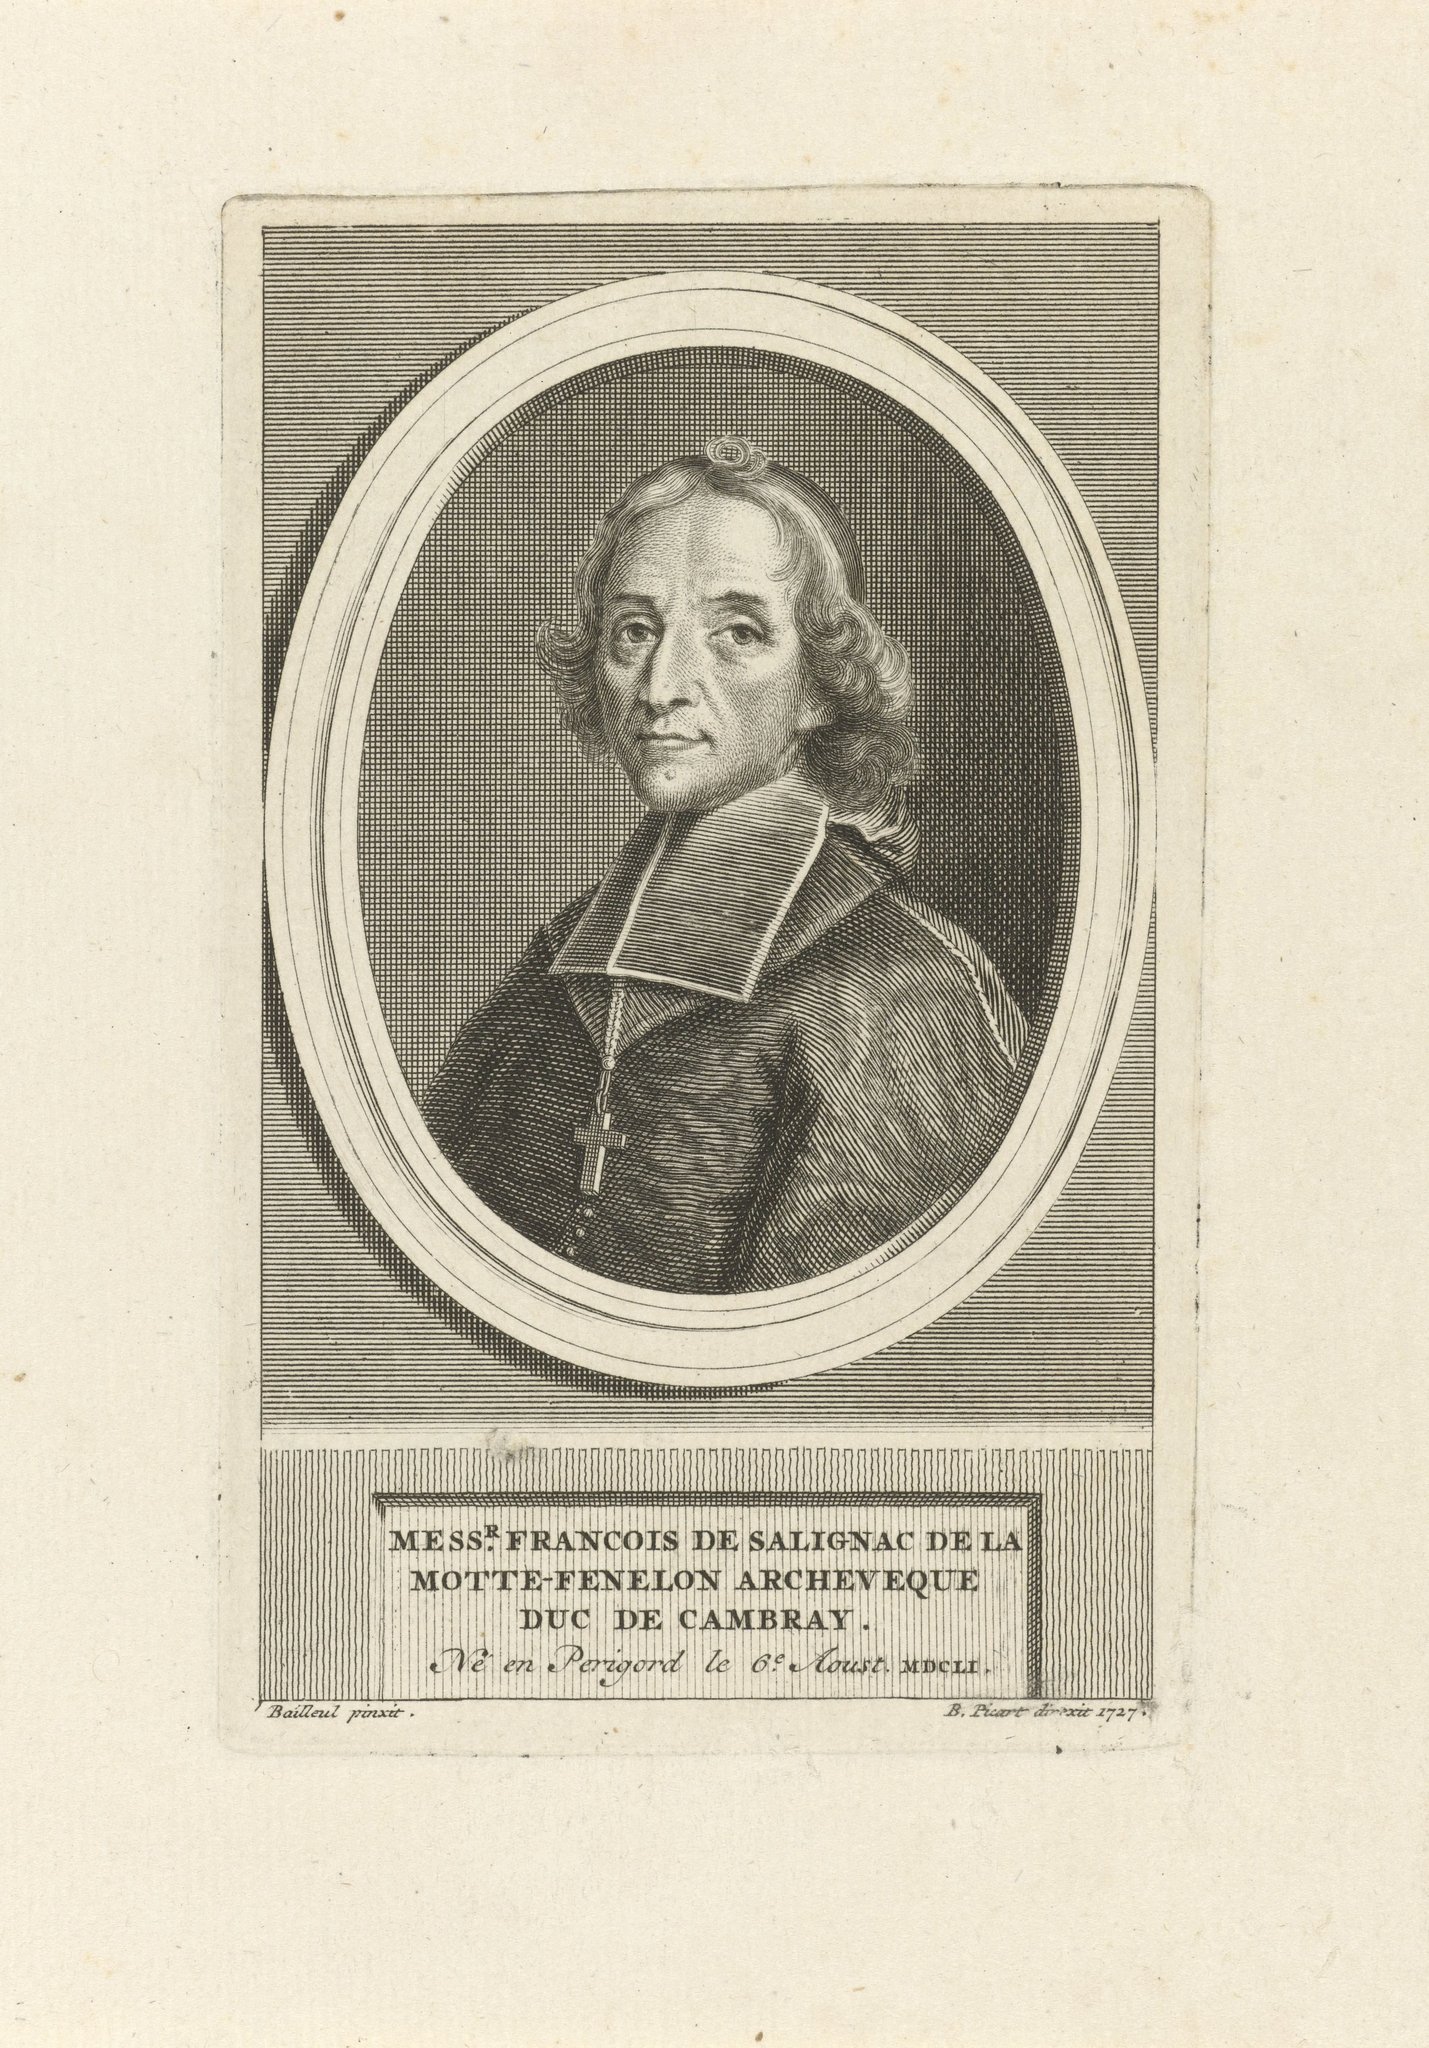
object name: print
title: Portret van François Fénelon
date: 1727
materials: paper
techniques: engraving, etching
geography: amsterdam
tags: françois fénelon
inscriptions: collector's mark: Lugt 2228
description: Portret van François de Salignac de la Mothe-Fénelon, aartsbisschop, theoloog en dichter.